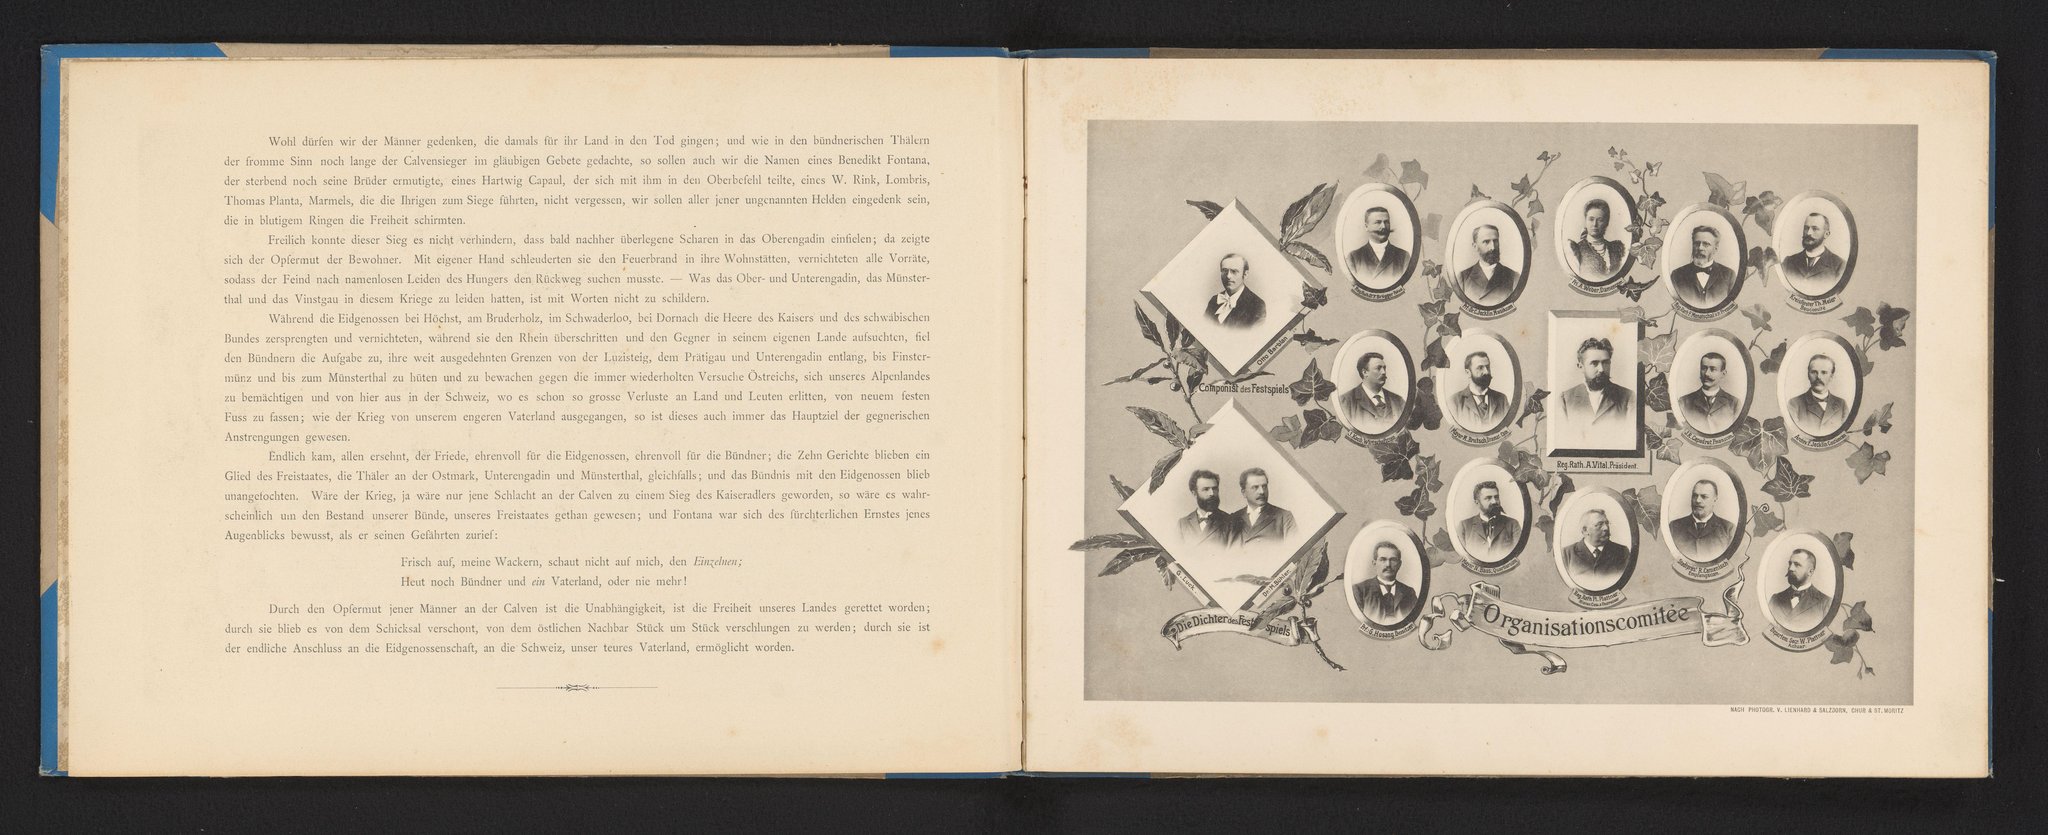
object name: montagefoto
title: Samengesteld groepsportret van het organisatiecomité van de Calven-Feier te Chur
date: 1898-1899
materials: paper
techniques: photograph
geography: chur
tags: committee members, board members